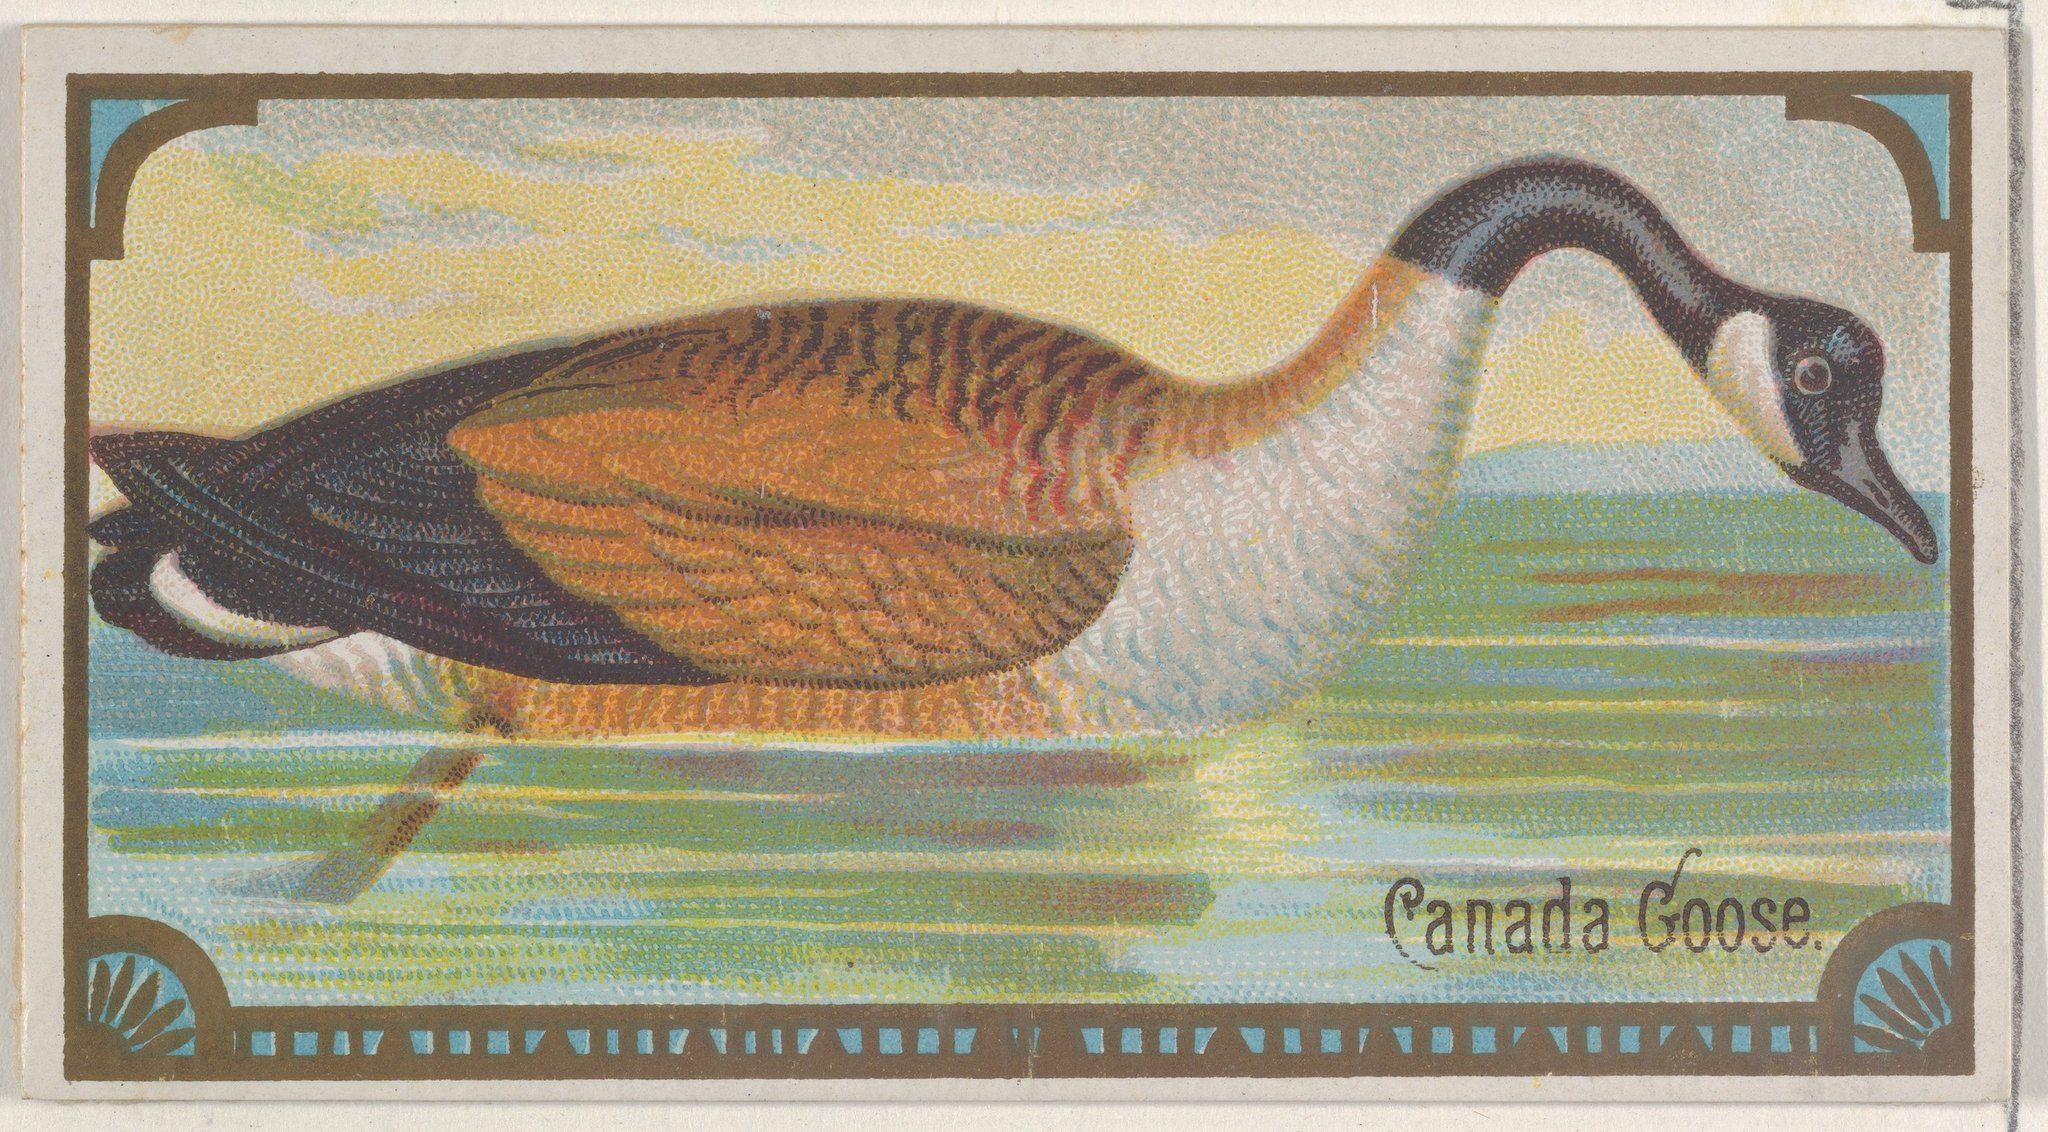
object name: print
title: Canada Goose, from the Game Birds series (N13) for Allen & Ginter Cigarettes Brands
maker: allen & ginter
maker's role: publisher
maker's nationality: american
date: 1889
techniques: color lithograph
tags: geese